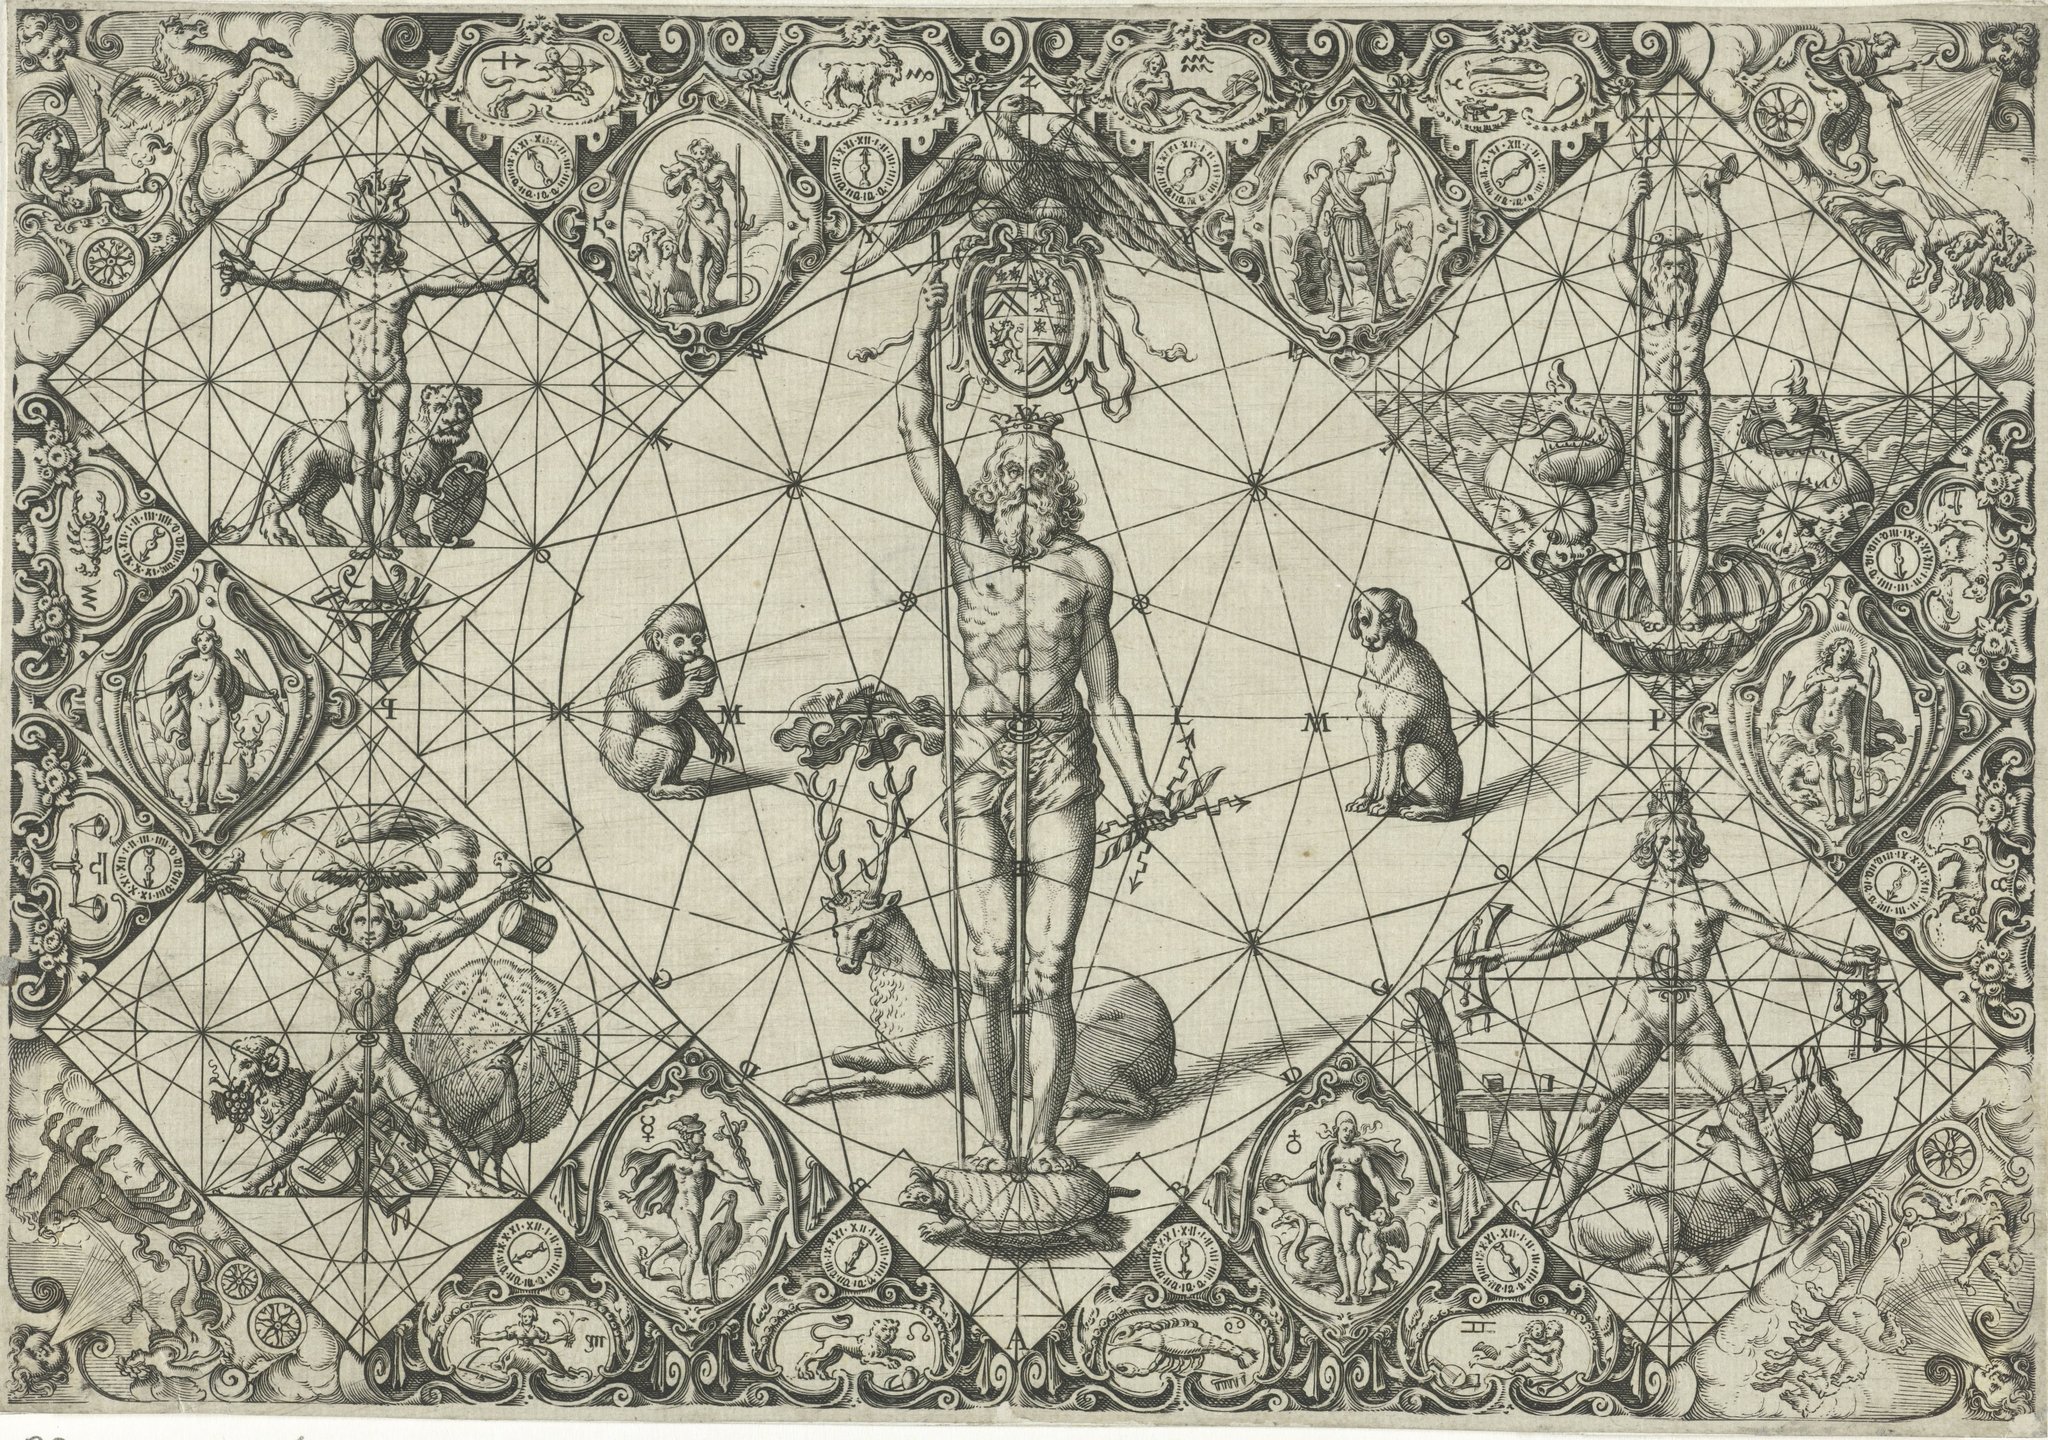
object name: print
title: Gekroonde Jupiter te midden van de elementen en planeten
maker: michiel le blon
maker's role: print maker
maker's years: 1587-1656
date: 1597-1656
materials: paper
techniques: engraving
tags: the four elements, and ether, the fifth element, the (five) senses, (story of) jupiter (zeus), winds, zodiac; the twelve zodiacal signs together, planets; planetary system, solar system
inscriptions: collector's mark: Lugt 2228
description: De gekroonde Jupiter staat binnen een cirkel op een schildpad en wordt omringd door dieren die de vijf zintuigen symboliseren: aap (smaak), hond (reuk), hert (gehoor), schildpad (gevoel) en adelaar (gezicht). Buiten de cirkel staan de vier elementen, de planeten, de winden en de dierenriemtekens weergegeven.